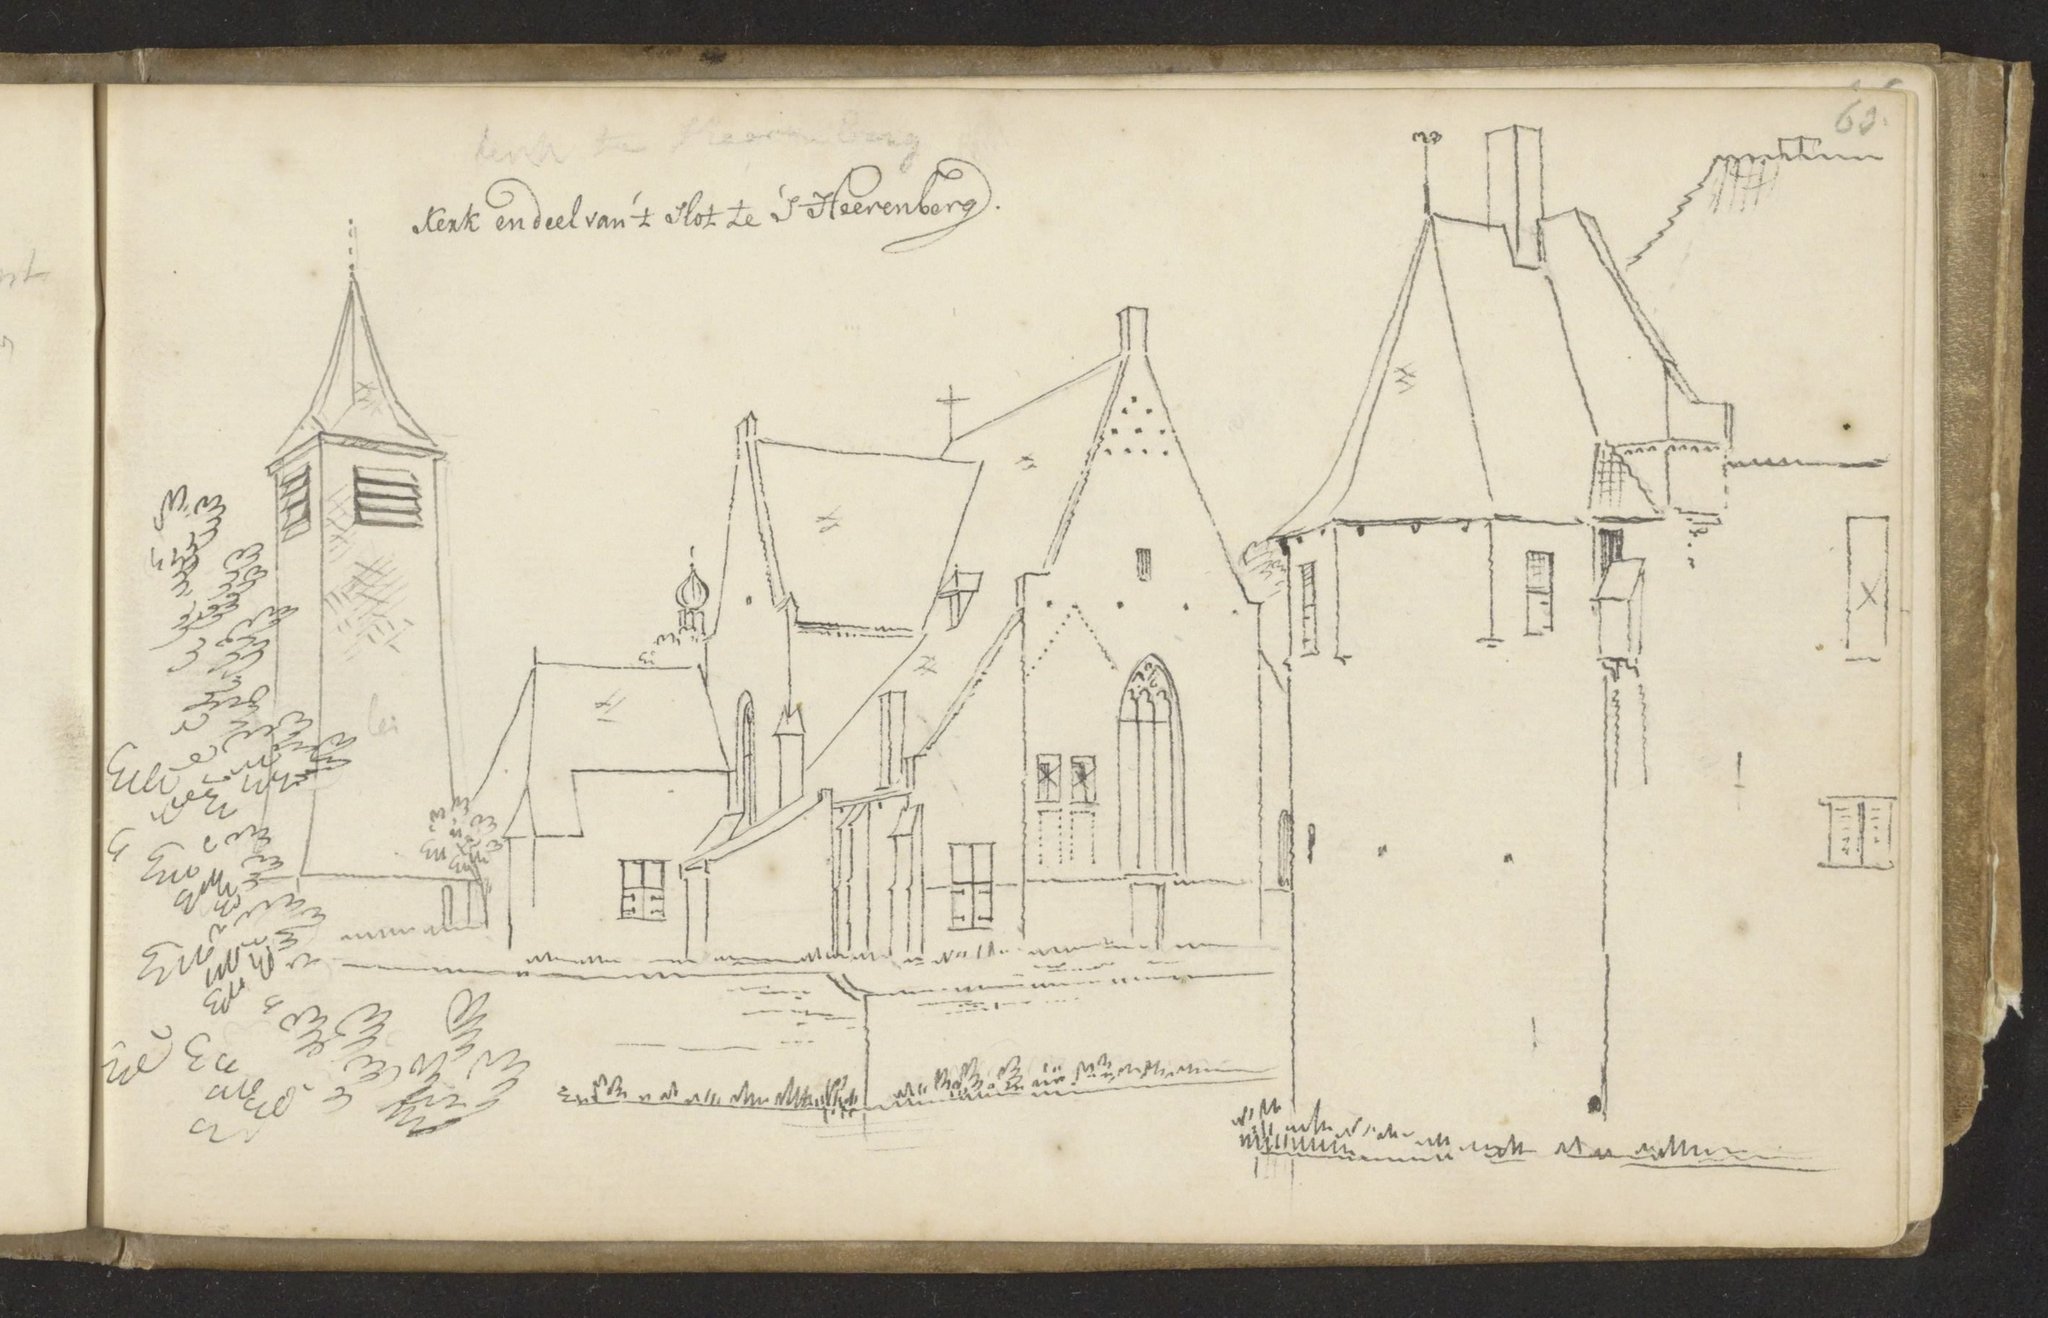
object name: sketchbook leaf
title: Kasteel Huis Bergh en kerk te 's-Heerenberg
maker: abraham de haen (ii)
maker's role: draughtsman, print maker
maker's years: 1707-1748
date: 1731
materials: ink, pencil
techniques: pen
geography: s-heerenberg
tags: castle, church (exterior)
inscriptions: annotation: ‘Kerk en deel van 't slot te 's-Heerenberg/ lei’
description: Blad 63 recto uit een schetsboek met 69 bladen.